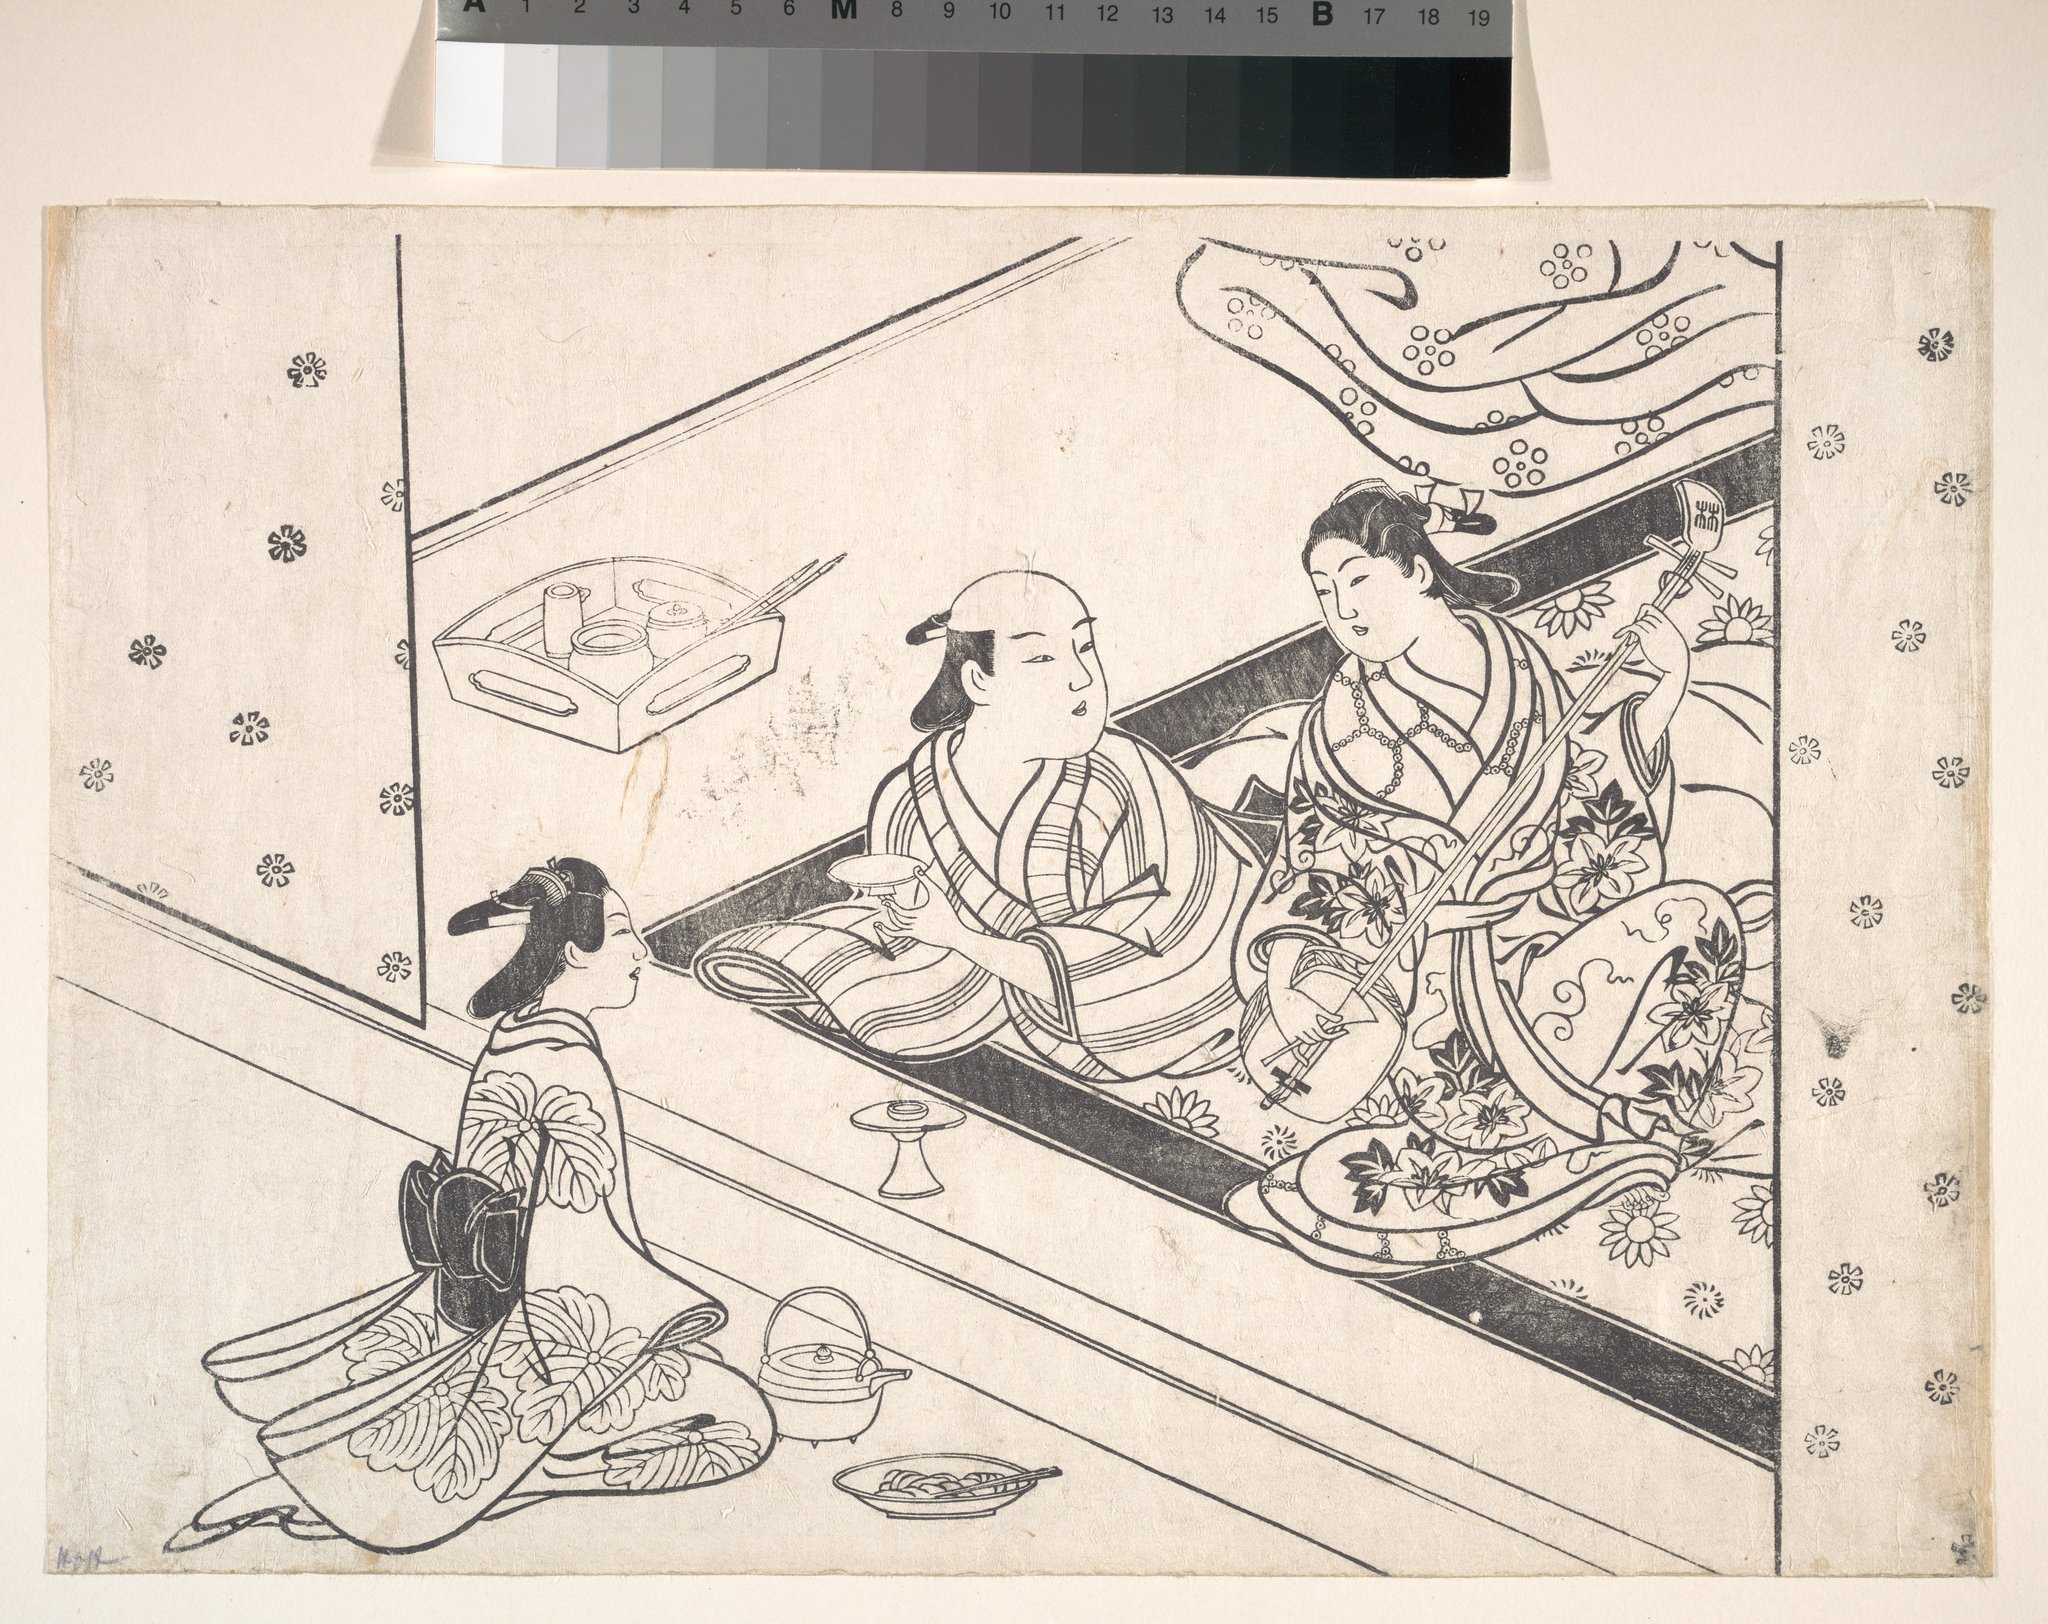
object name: print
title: Lady Playing Shamisen, with Her Lover and Attendant Nearby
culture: japanese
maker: nishikawa sukenobu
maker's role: artist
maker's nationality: japanese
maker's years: 1671-1750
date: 1671-1751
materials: ink, paper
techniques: woodblock print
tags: musical instruments,men,lovers,women